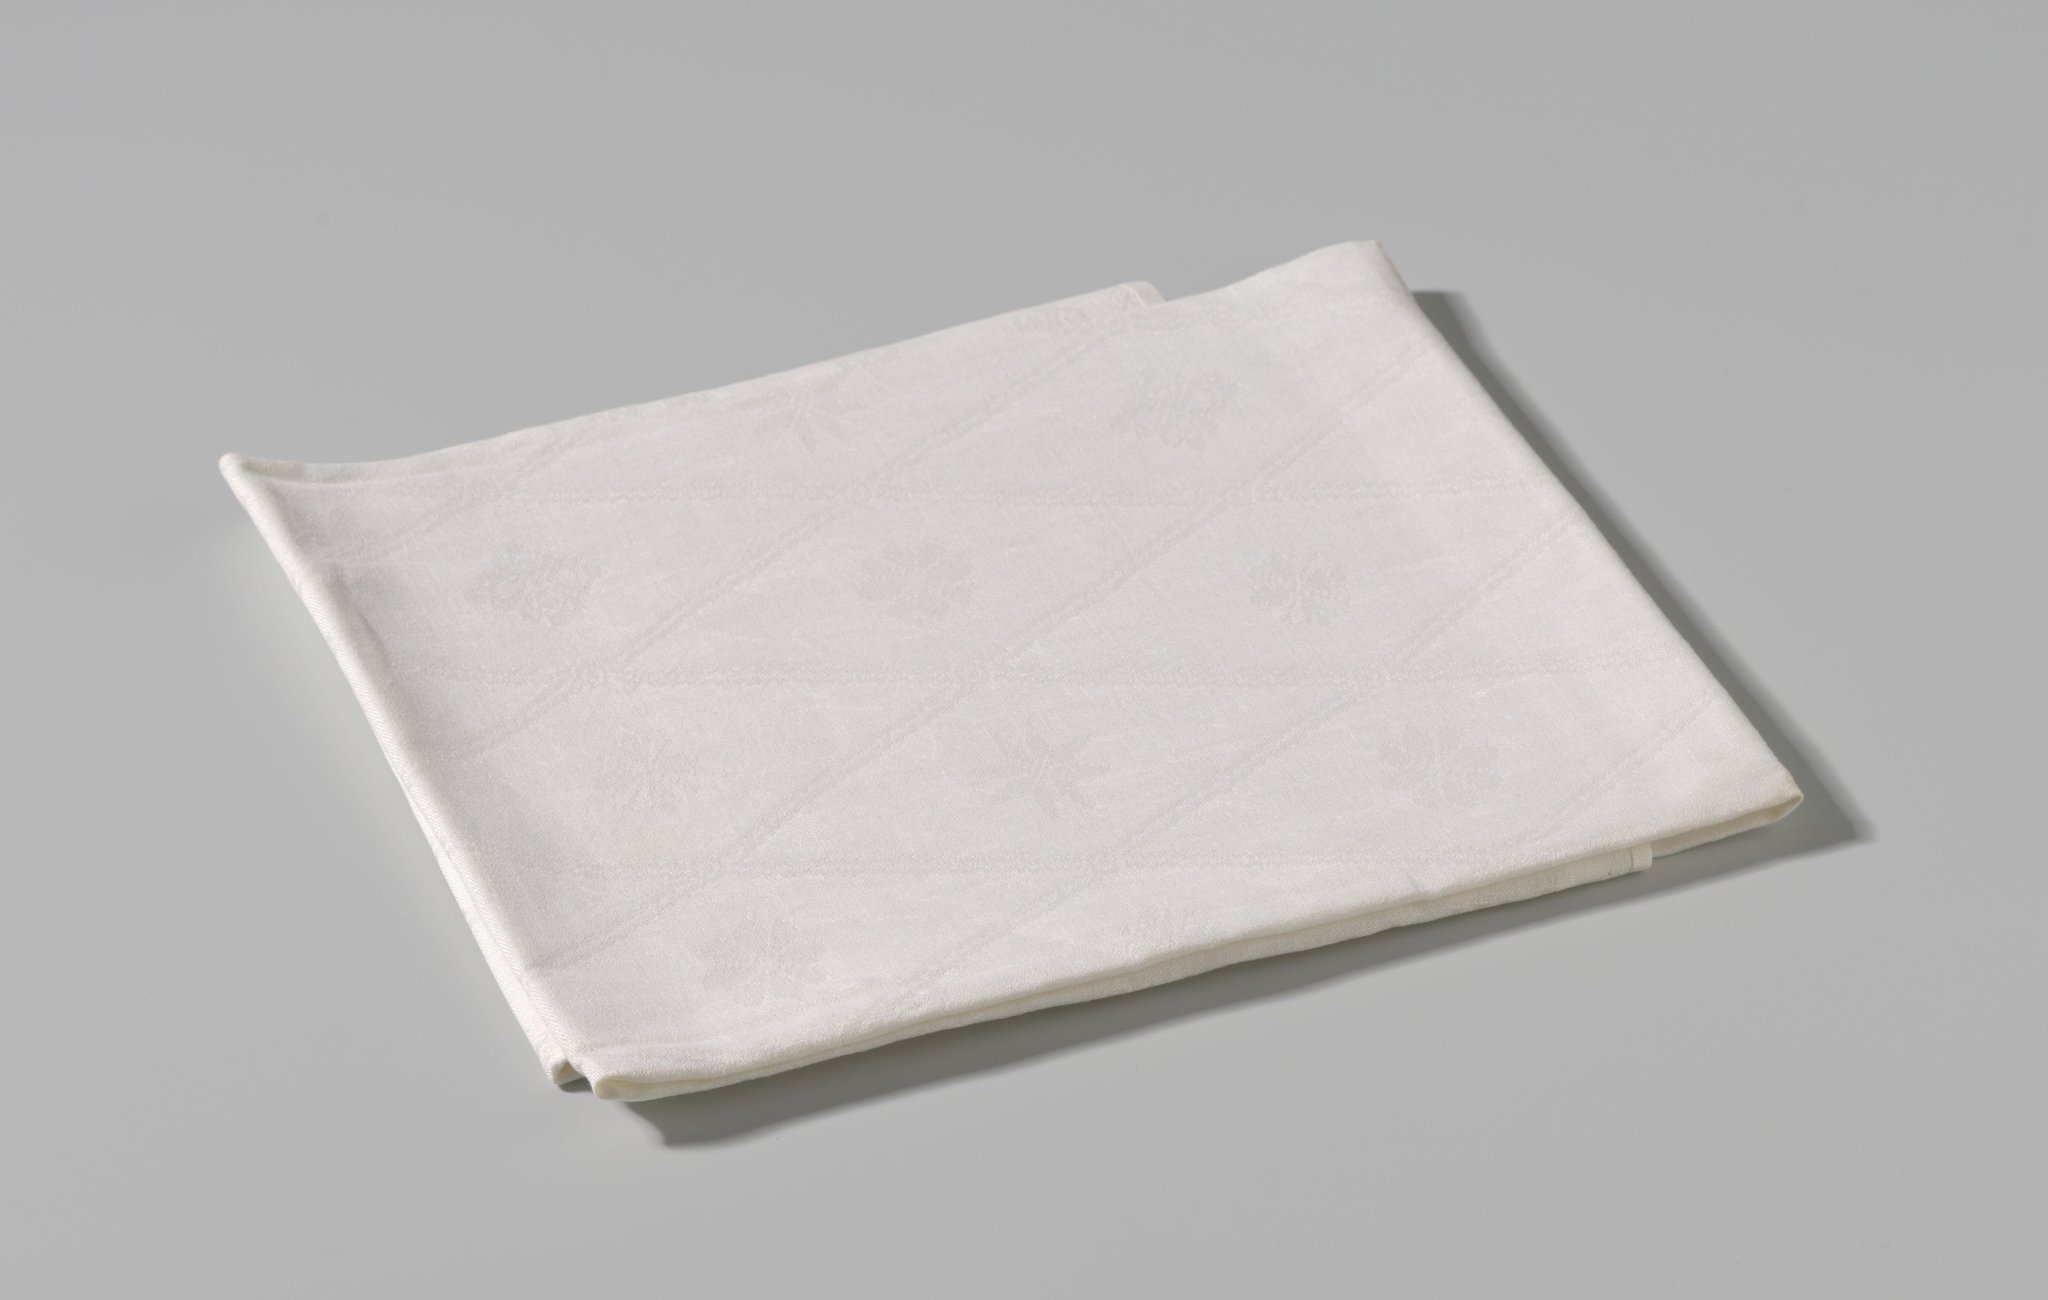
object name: napkin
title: Servet van linnendamast met een bloempatroon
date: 1825-1850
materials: linen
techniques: damask, weave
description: Servet van linnendamast met een bloempatroon. Het veld heeft ruiten waarbinnen gestileerde bloemen en sterren, de randen knoestig hout (Griekse rand). Het servet is gemerkt met bindgat letters: VI 18.